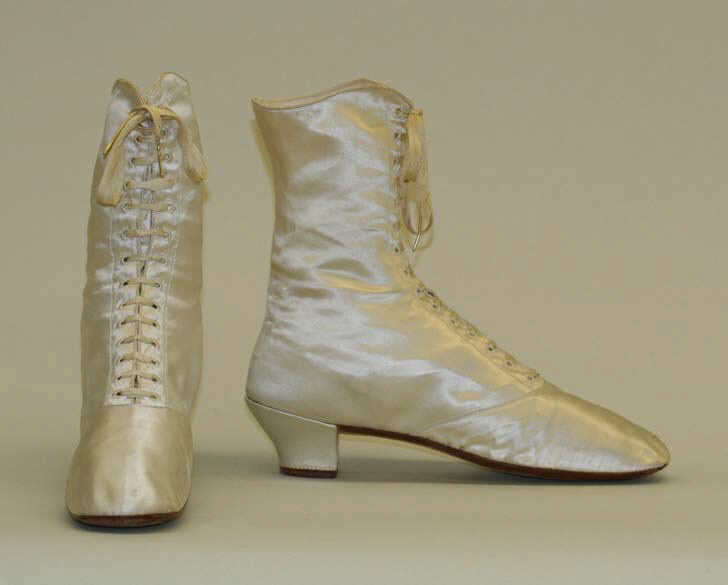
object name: shoe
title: Shoes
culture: american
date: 1860-1879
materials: silk